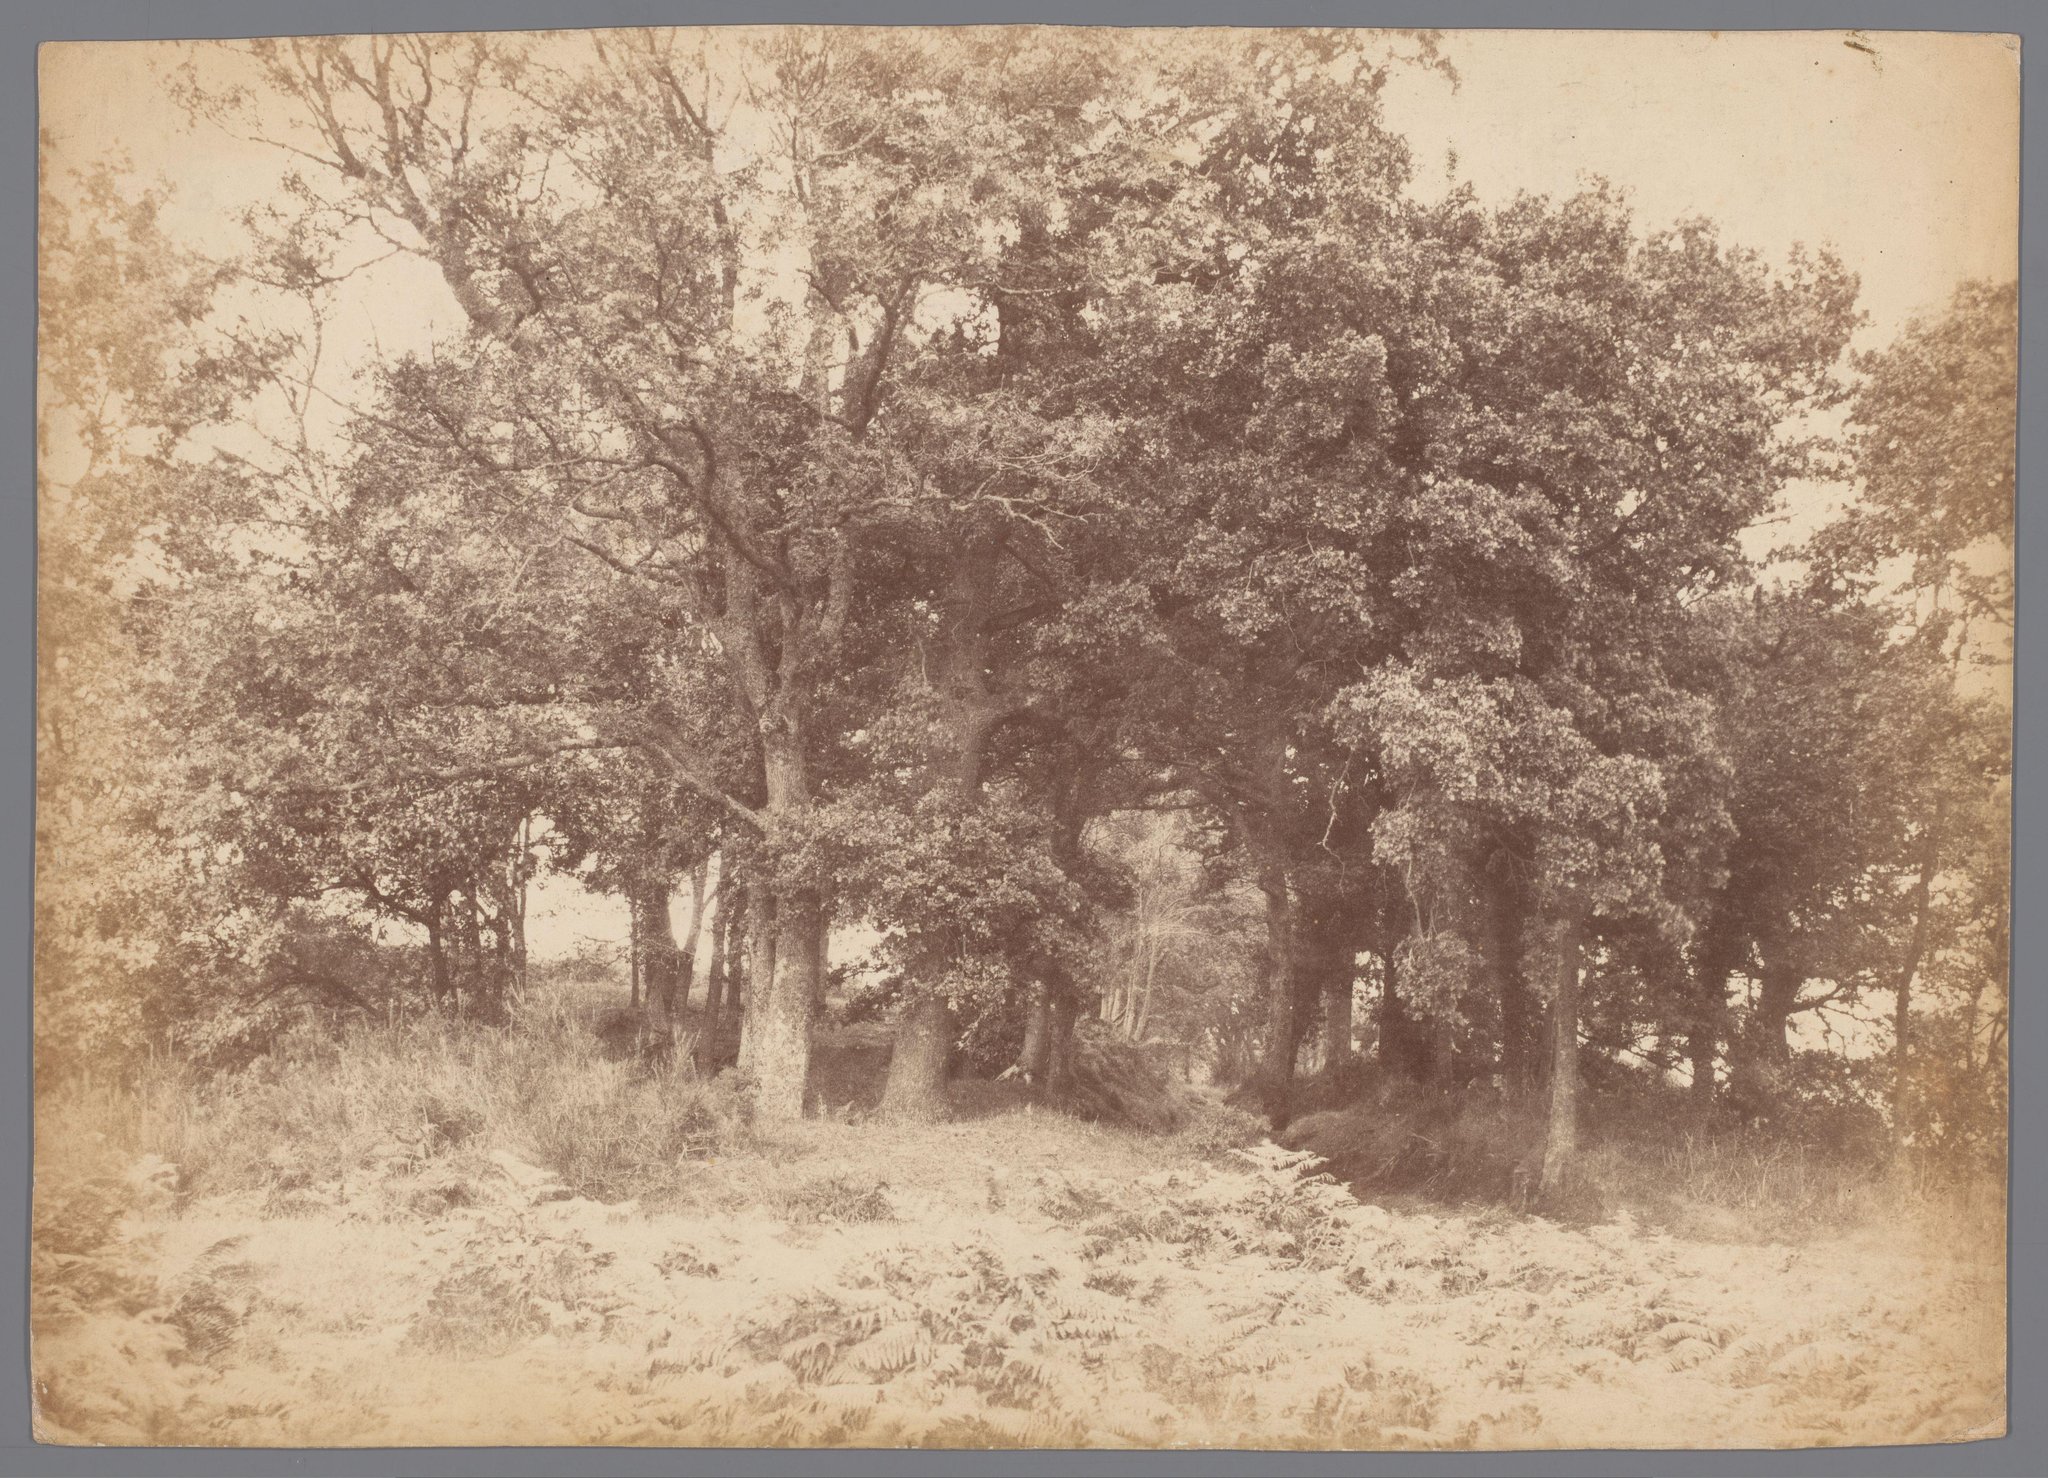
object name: photograph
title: Gezicht in bos/park, Engeland [?]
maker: Anonymous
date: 1860-1880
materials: cardboard, photographic support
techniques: albumen print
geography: england